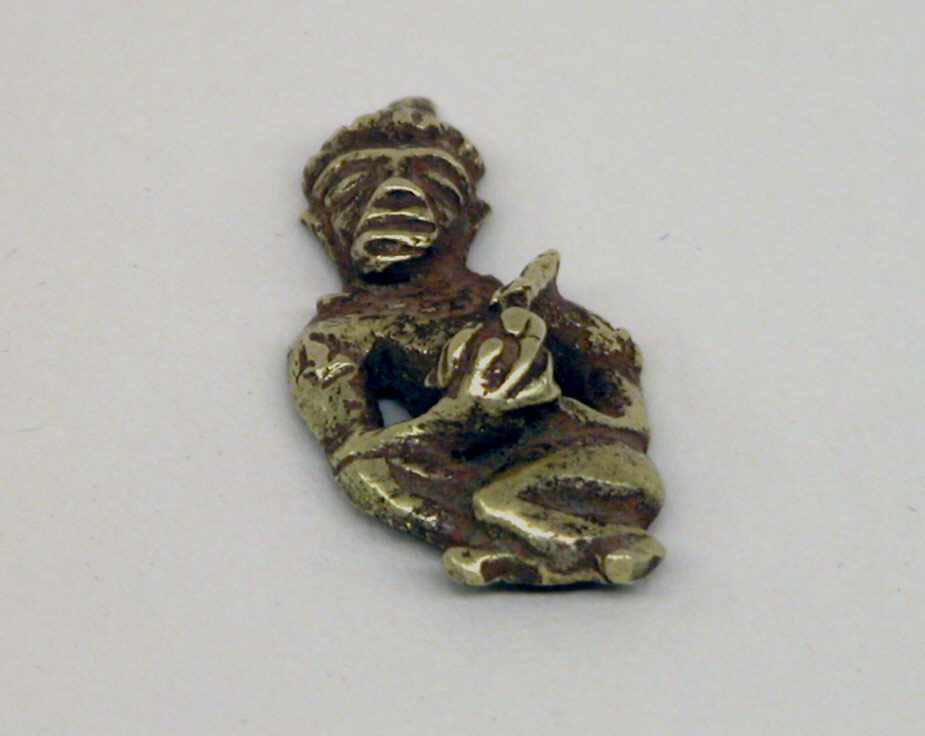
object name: figurine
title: Three Figurines of Deities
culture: indonesian, javanese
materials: gold